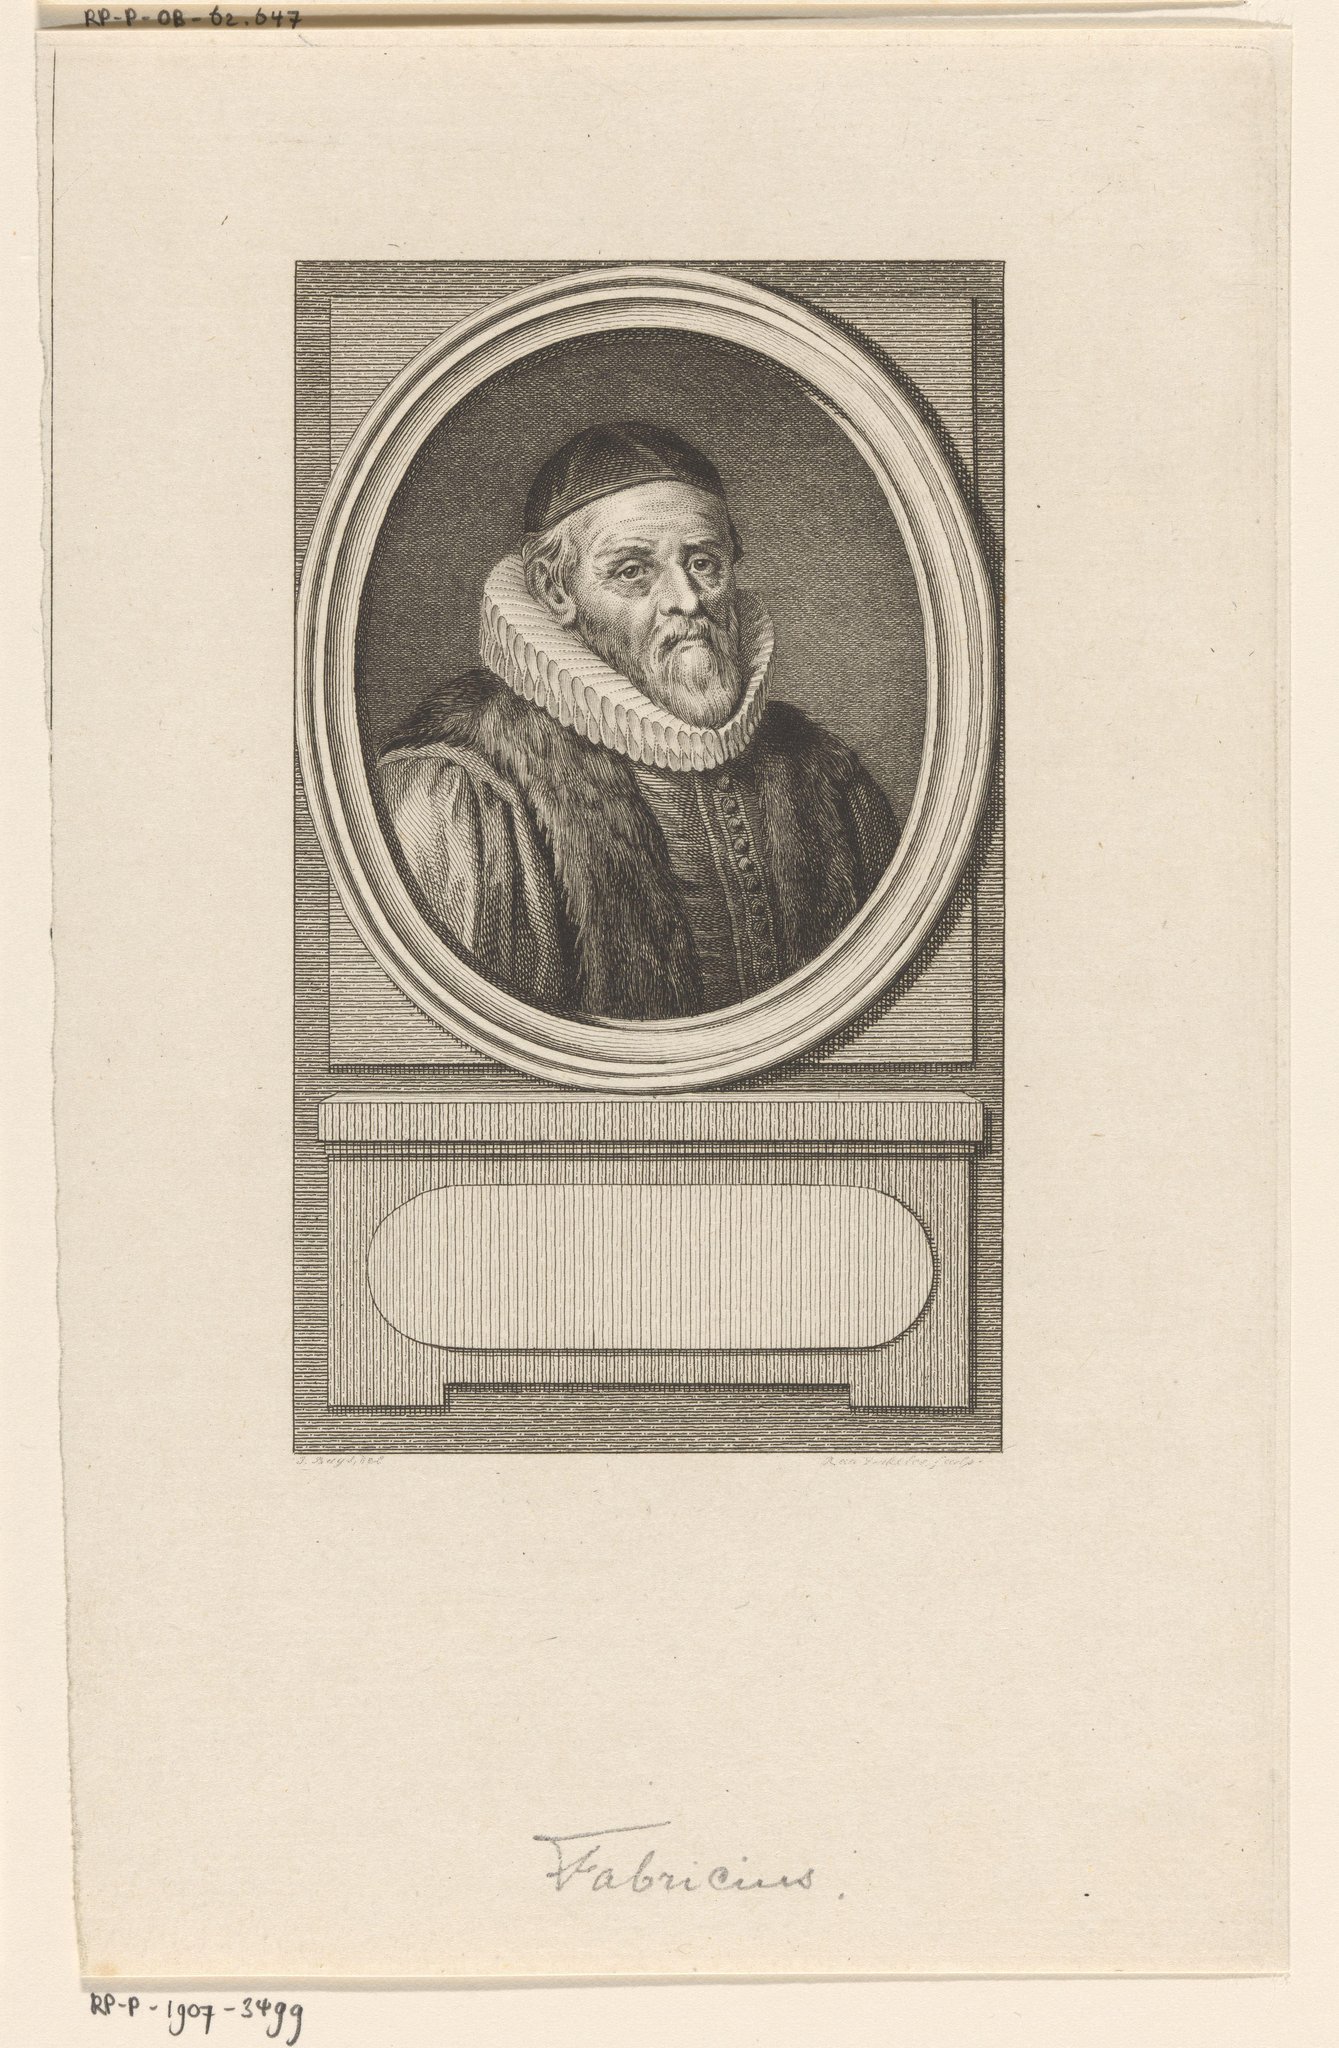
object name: print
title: Portret van Arent Meyndertsz Fabricius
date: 1786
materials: paper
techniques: etching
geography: amsterdam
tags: haarlem, mayor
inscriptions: collector's mark: Lugt 2228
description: Latere staat prent gebruikt als boekillustratie in: Kok, Jacobus. Vaderlandsch woordenboek : met kaarten, plaaten en pourtraitten. Amsterdam: Johannes Allart, 1785-1796. Deel XV.